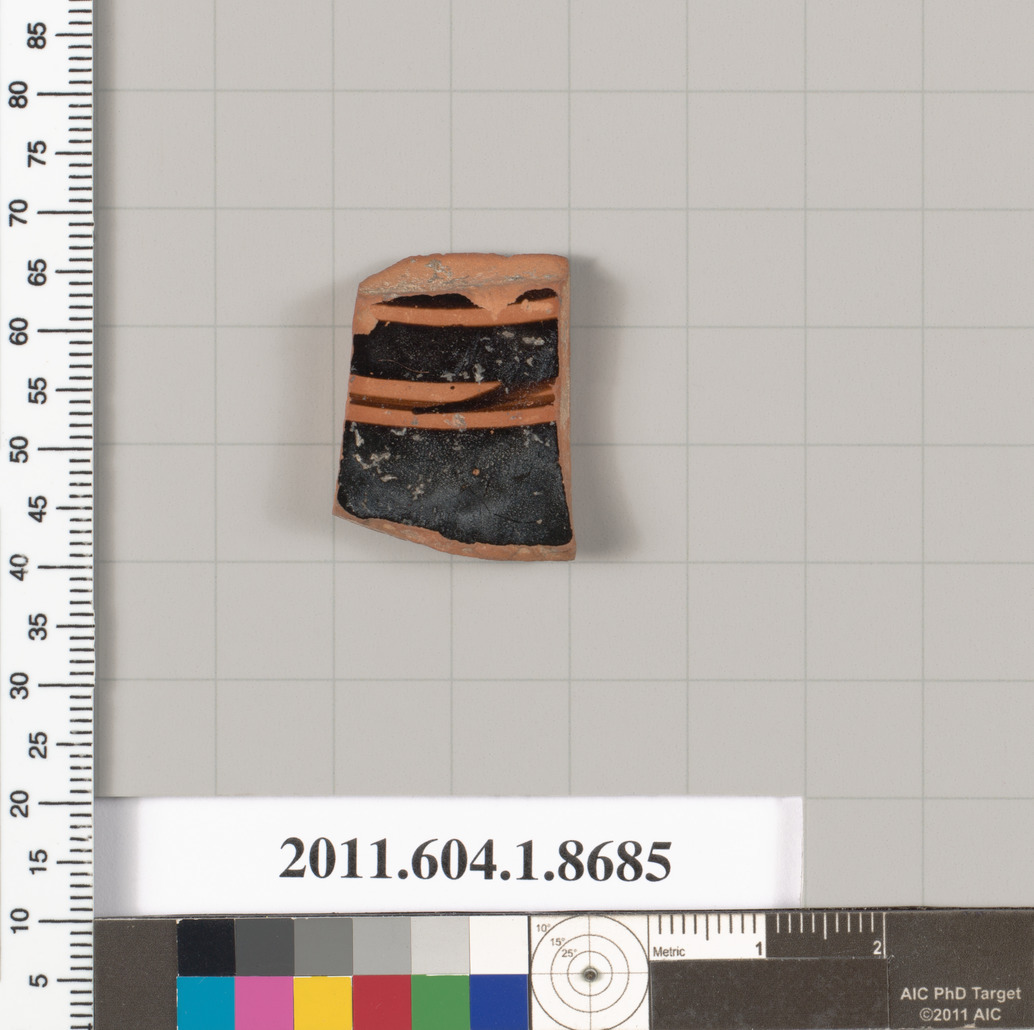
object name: kylix fragment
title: Terracotta fragment of a stemless kylix (drinking cup)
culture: greek, attic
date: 460-450 BCE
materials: terracotta